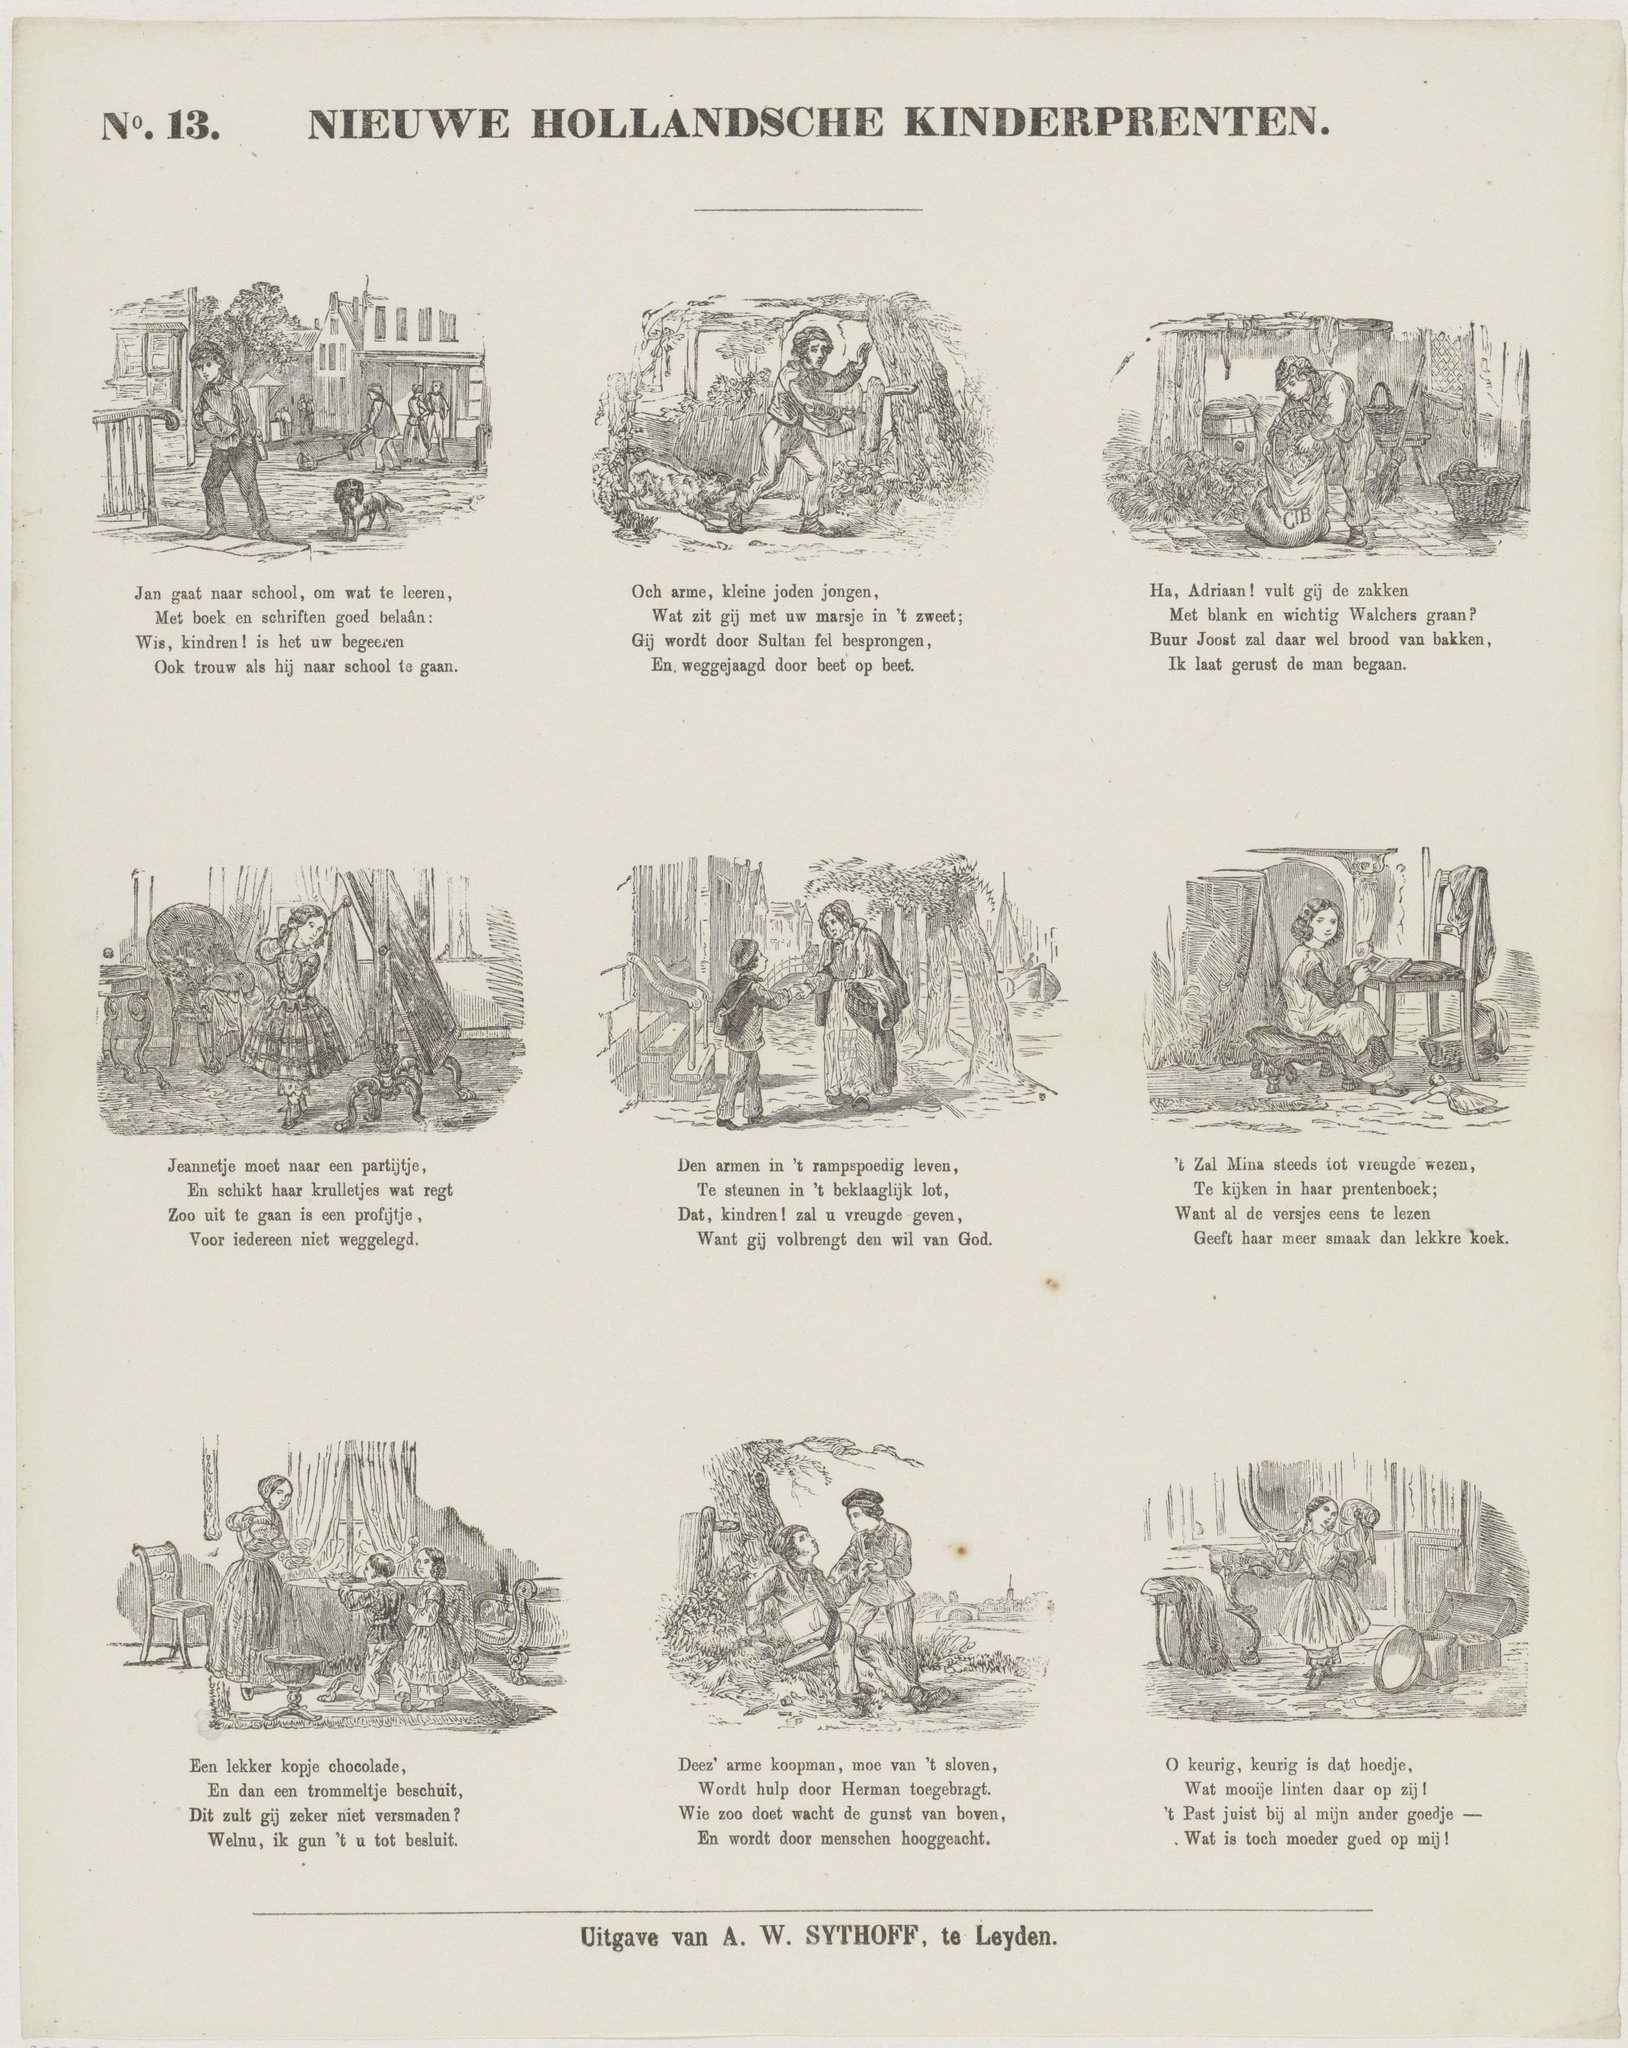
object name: popular print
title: Nieuwe Hollandsche kinderprenten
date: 1861-1929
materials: paper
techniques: letterpress printing, engraving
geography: europe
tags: human types, child, characters (human types), good behaviour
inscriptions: collector's mark: Lugt 2760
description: Blad met 9 voorstellingen van verschillende aard, zoals voorstellingen van een jongen die naar school gaat, van een meisje die voor de spiegel staat en van twee kinderen die een kopje warme chocolade krijgen. Onder elke voorstelling een vierregelig vers. Genummerd linksboven: No. 13.